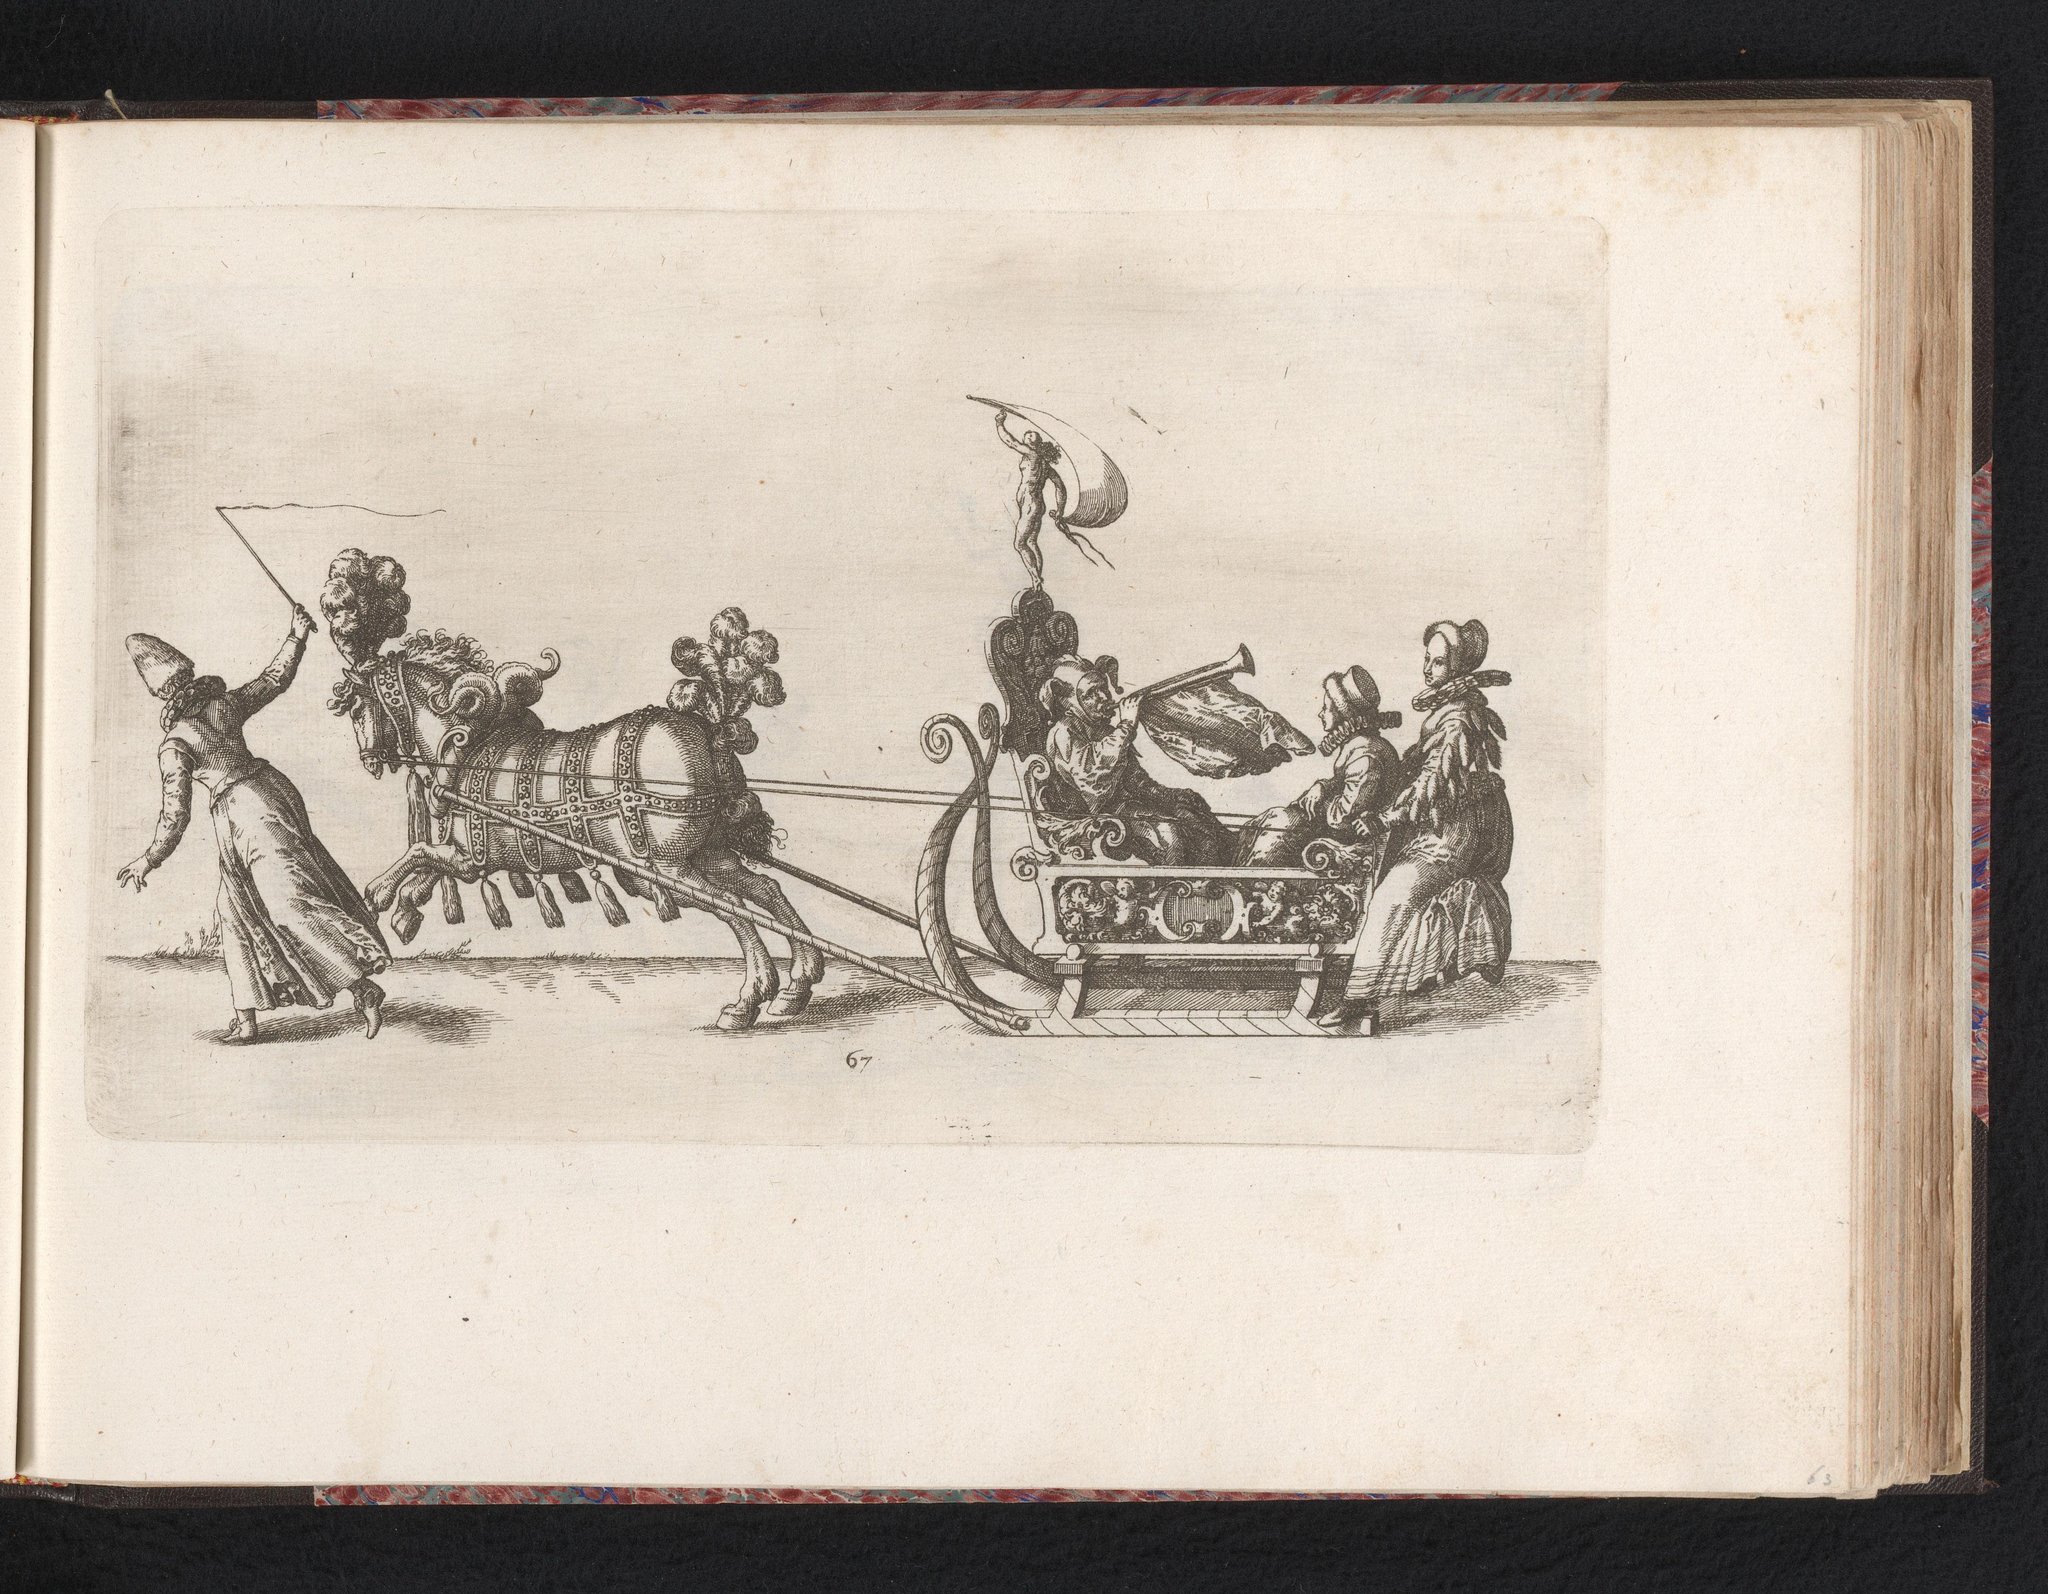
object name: album leaf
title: Nar en twee vrouwen in een slee getrokken door een paard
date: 1618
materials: paper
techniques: etching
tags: court jester, court fool, horse-sleigh, performance in the open air (pleasure fair)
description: Genummerd: 67. Deze prent maakt deel uit van een album.